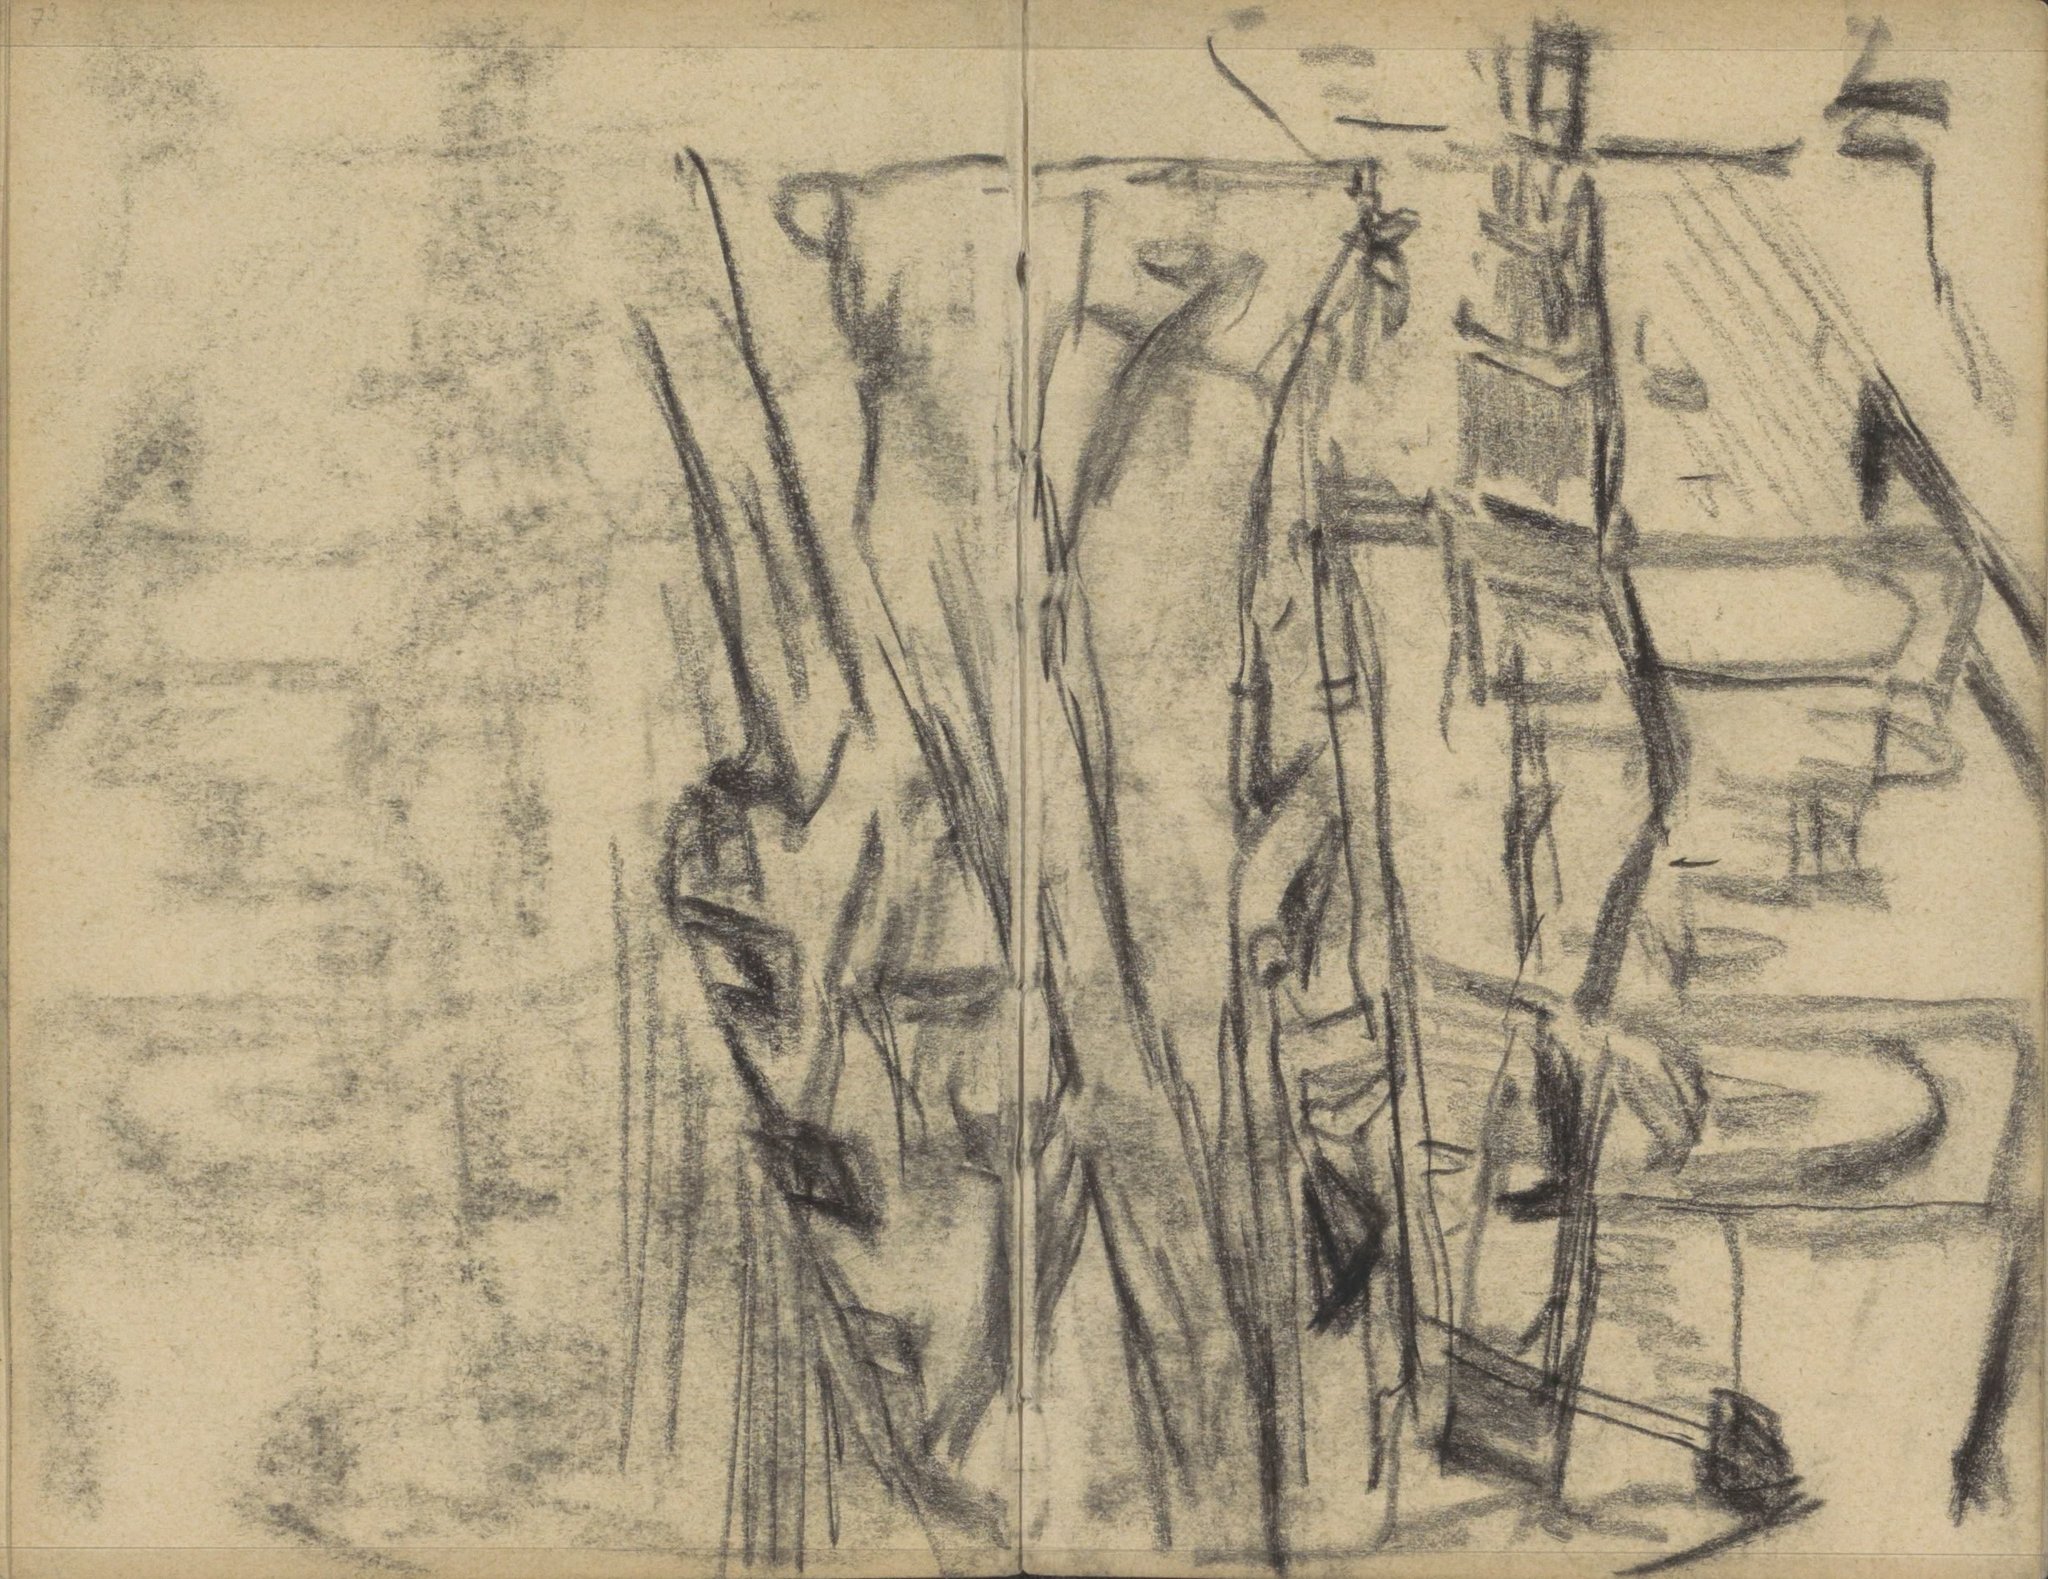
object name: sketchbook leaf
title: Gezicht op de Prinseneilandsgracht met de Sloterdijkerbrug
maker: george hendrik breitner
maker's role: draughtsman, painter, print maker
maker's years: 1857-1923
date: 1907-1909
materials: chalk, paper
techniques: stumping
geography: amsterdam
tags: ships (in general), bridge in city across river, canal, etc.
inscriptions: kleurnotitie, handgeschreven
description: Gezicht op de Prinseneilandsgracht met de Sloterdijkerbrug. Vooraan een aangemeerde boot. Pagina 73 en pagina 74 uit een schetsboek met 46 bladen vervaardigd te Antwerpen, Gent en Amsterdam.